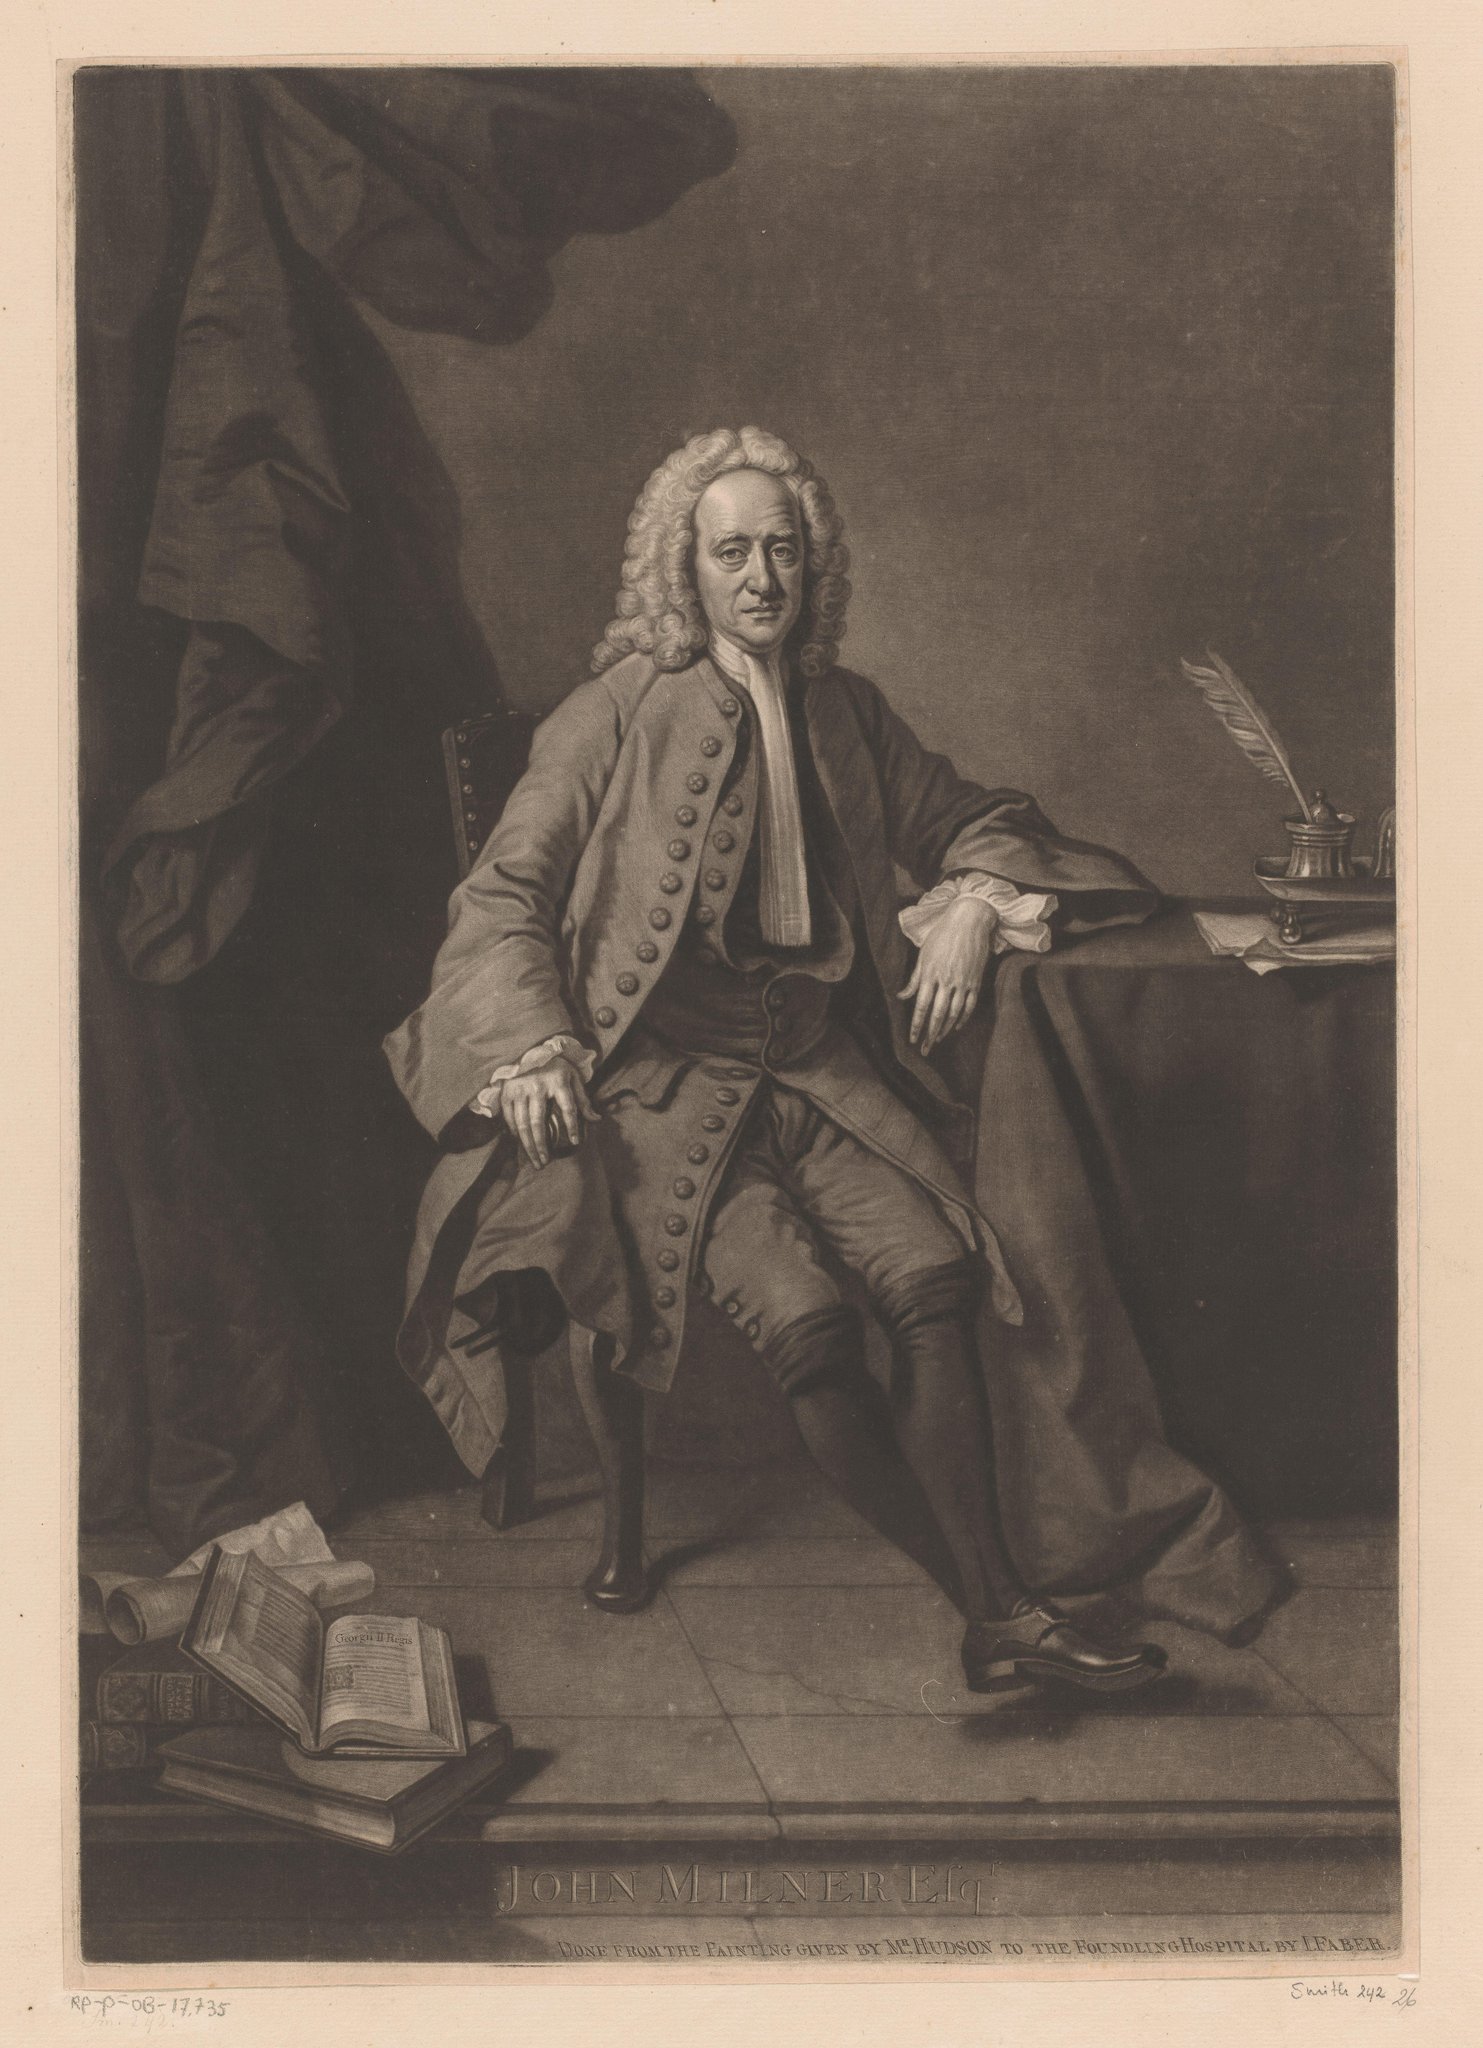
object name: print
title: Portret van John Milner Esqr.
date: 1711-1756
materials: paper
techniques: etching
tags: historical persons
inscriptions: collector's mark: Lugt 240